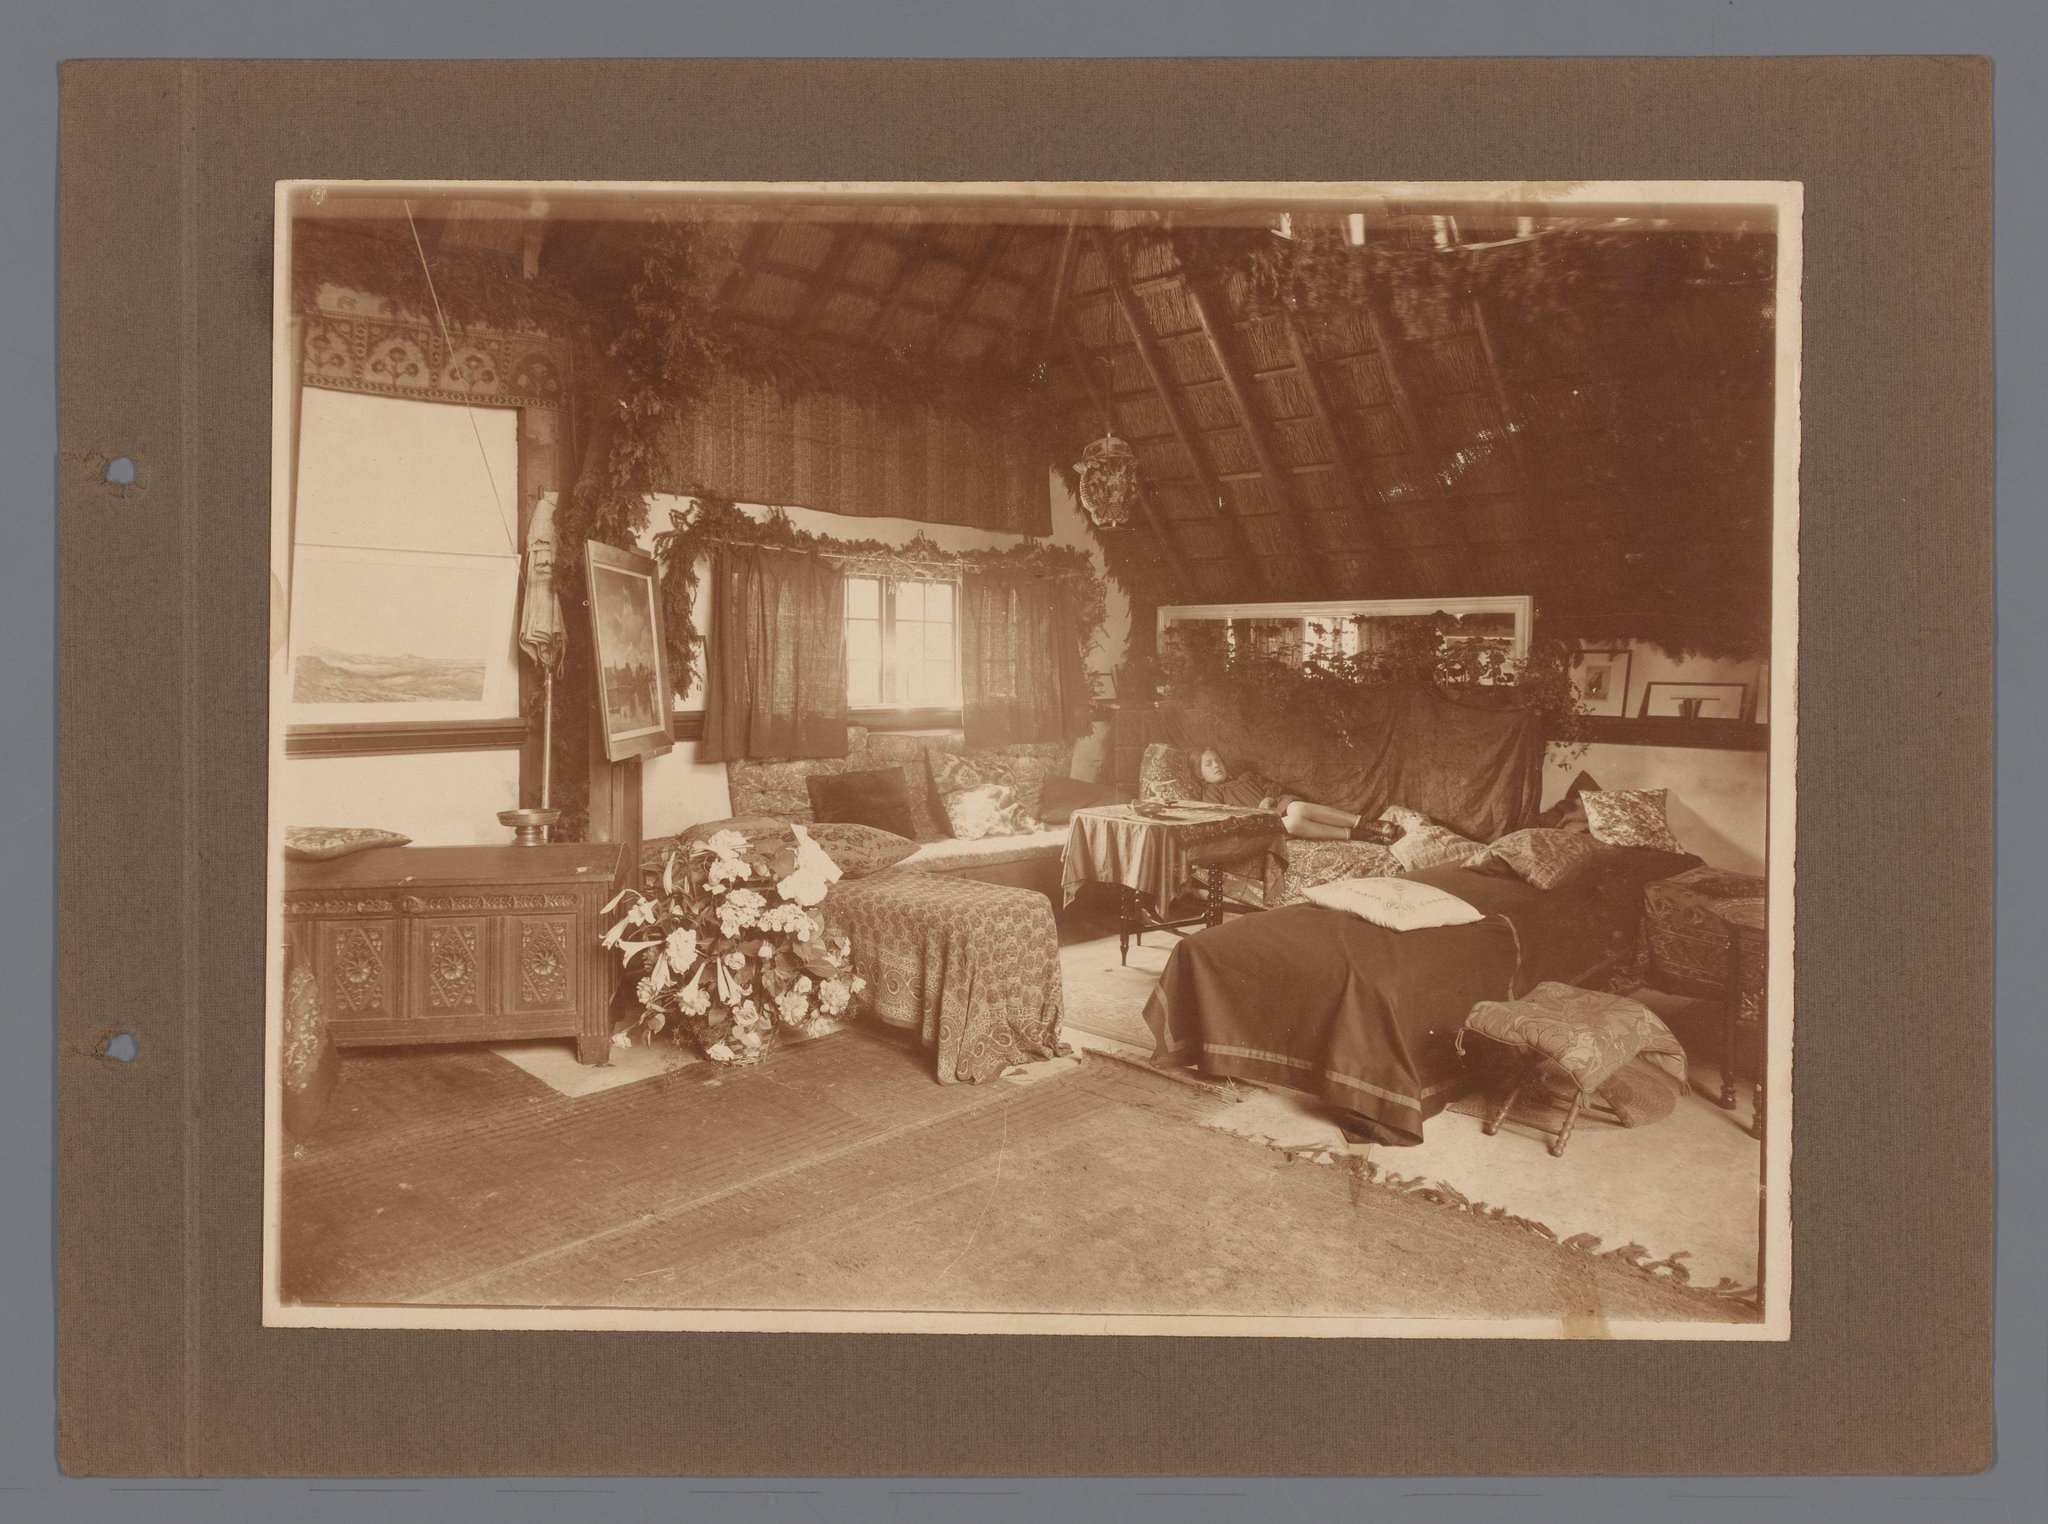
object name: album leaf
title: Meisje liggende op divan/bed in interieur, ca. 1916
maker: Anonymous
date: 1916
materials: cardboard, photographic support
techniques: gelatin silver print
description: Meisje liggend op divan/bed in interieur, ca. 1916. Interieur met hoge rieten overkapping. Meerdere bedden, banken, bloemen en kunst aan de muur en op de grond. Vergelijk RP-F-00-6023: zelfde album, zelfde interieur (hetzelfde ingelijst landschap hier links op de foto, in ander albumblad rechts).